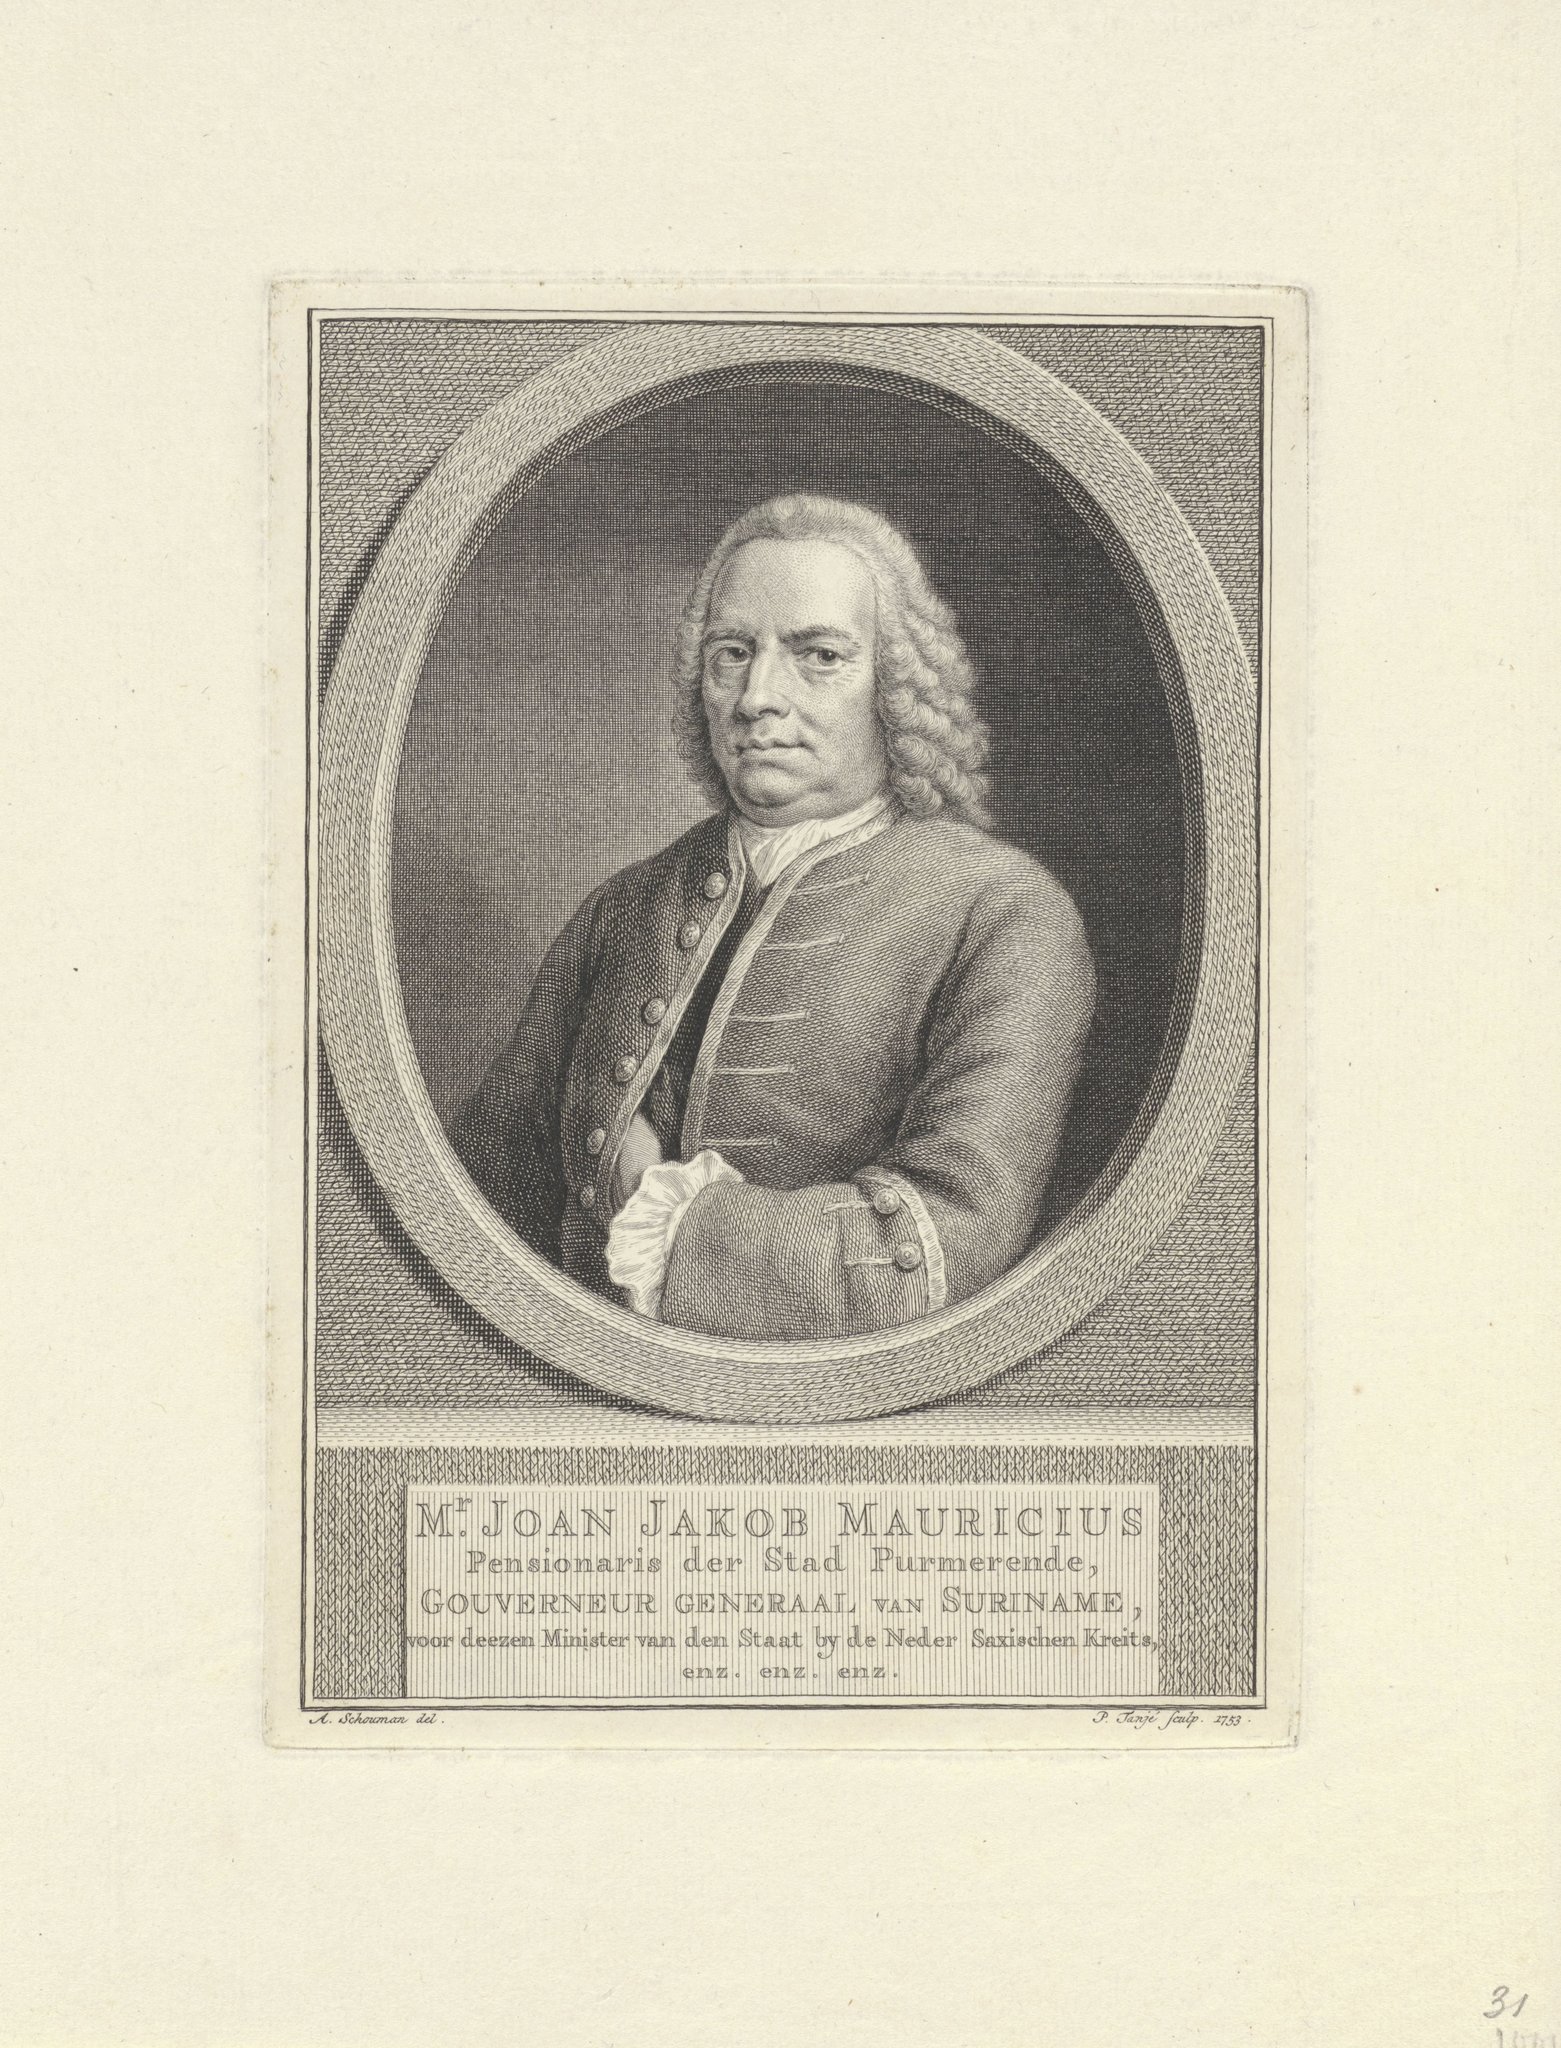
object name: print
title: Portret van Joan Jacob Mauricius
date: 1753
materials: paper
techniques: engraving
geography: amsterdam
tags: joan jacob mauricius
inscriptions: collector's mark: Lugt 240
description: Portret van Joan Jacob Mauricius, schepen en pensionaris van Purmerend en gouverneur van Suriname.